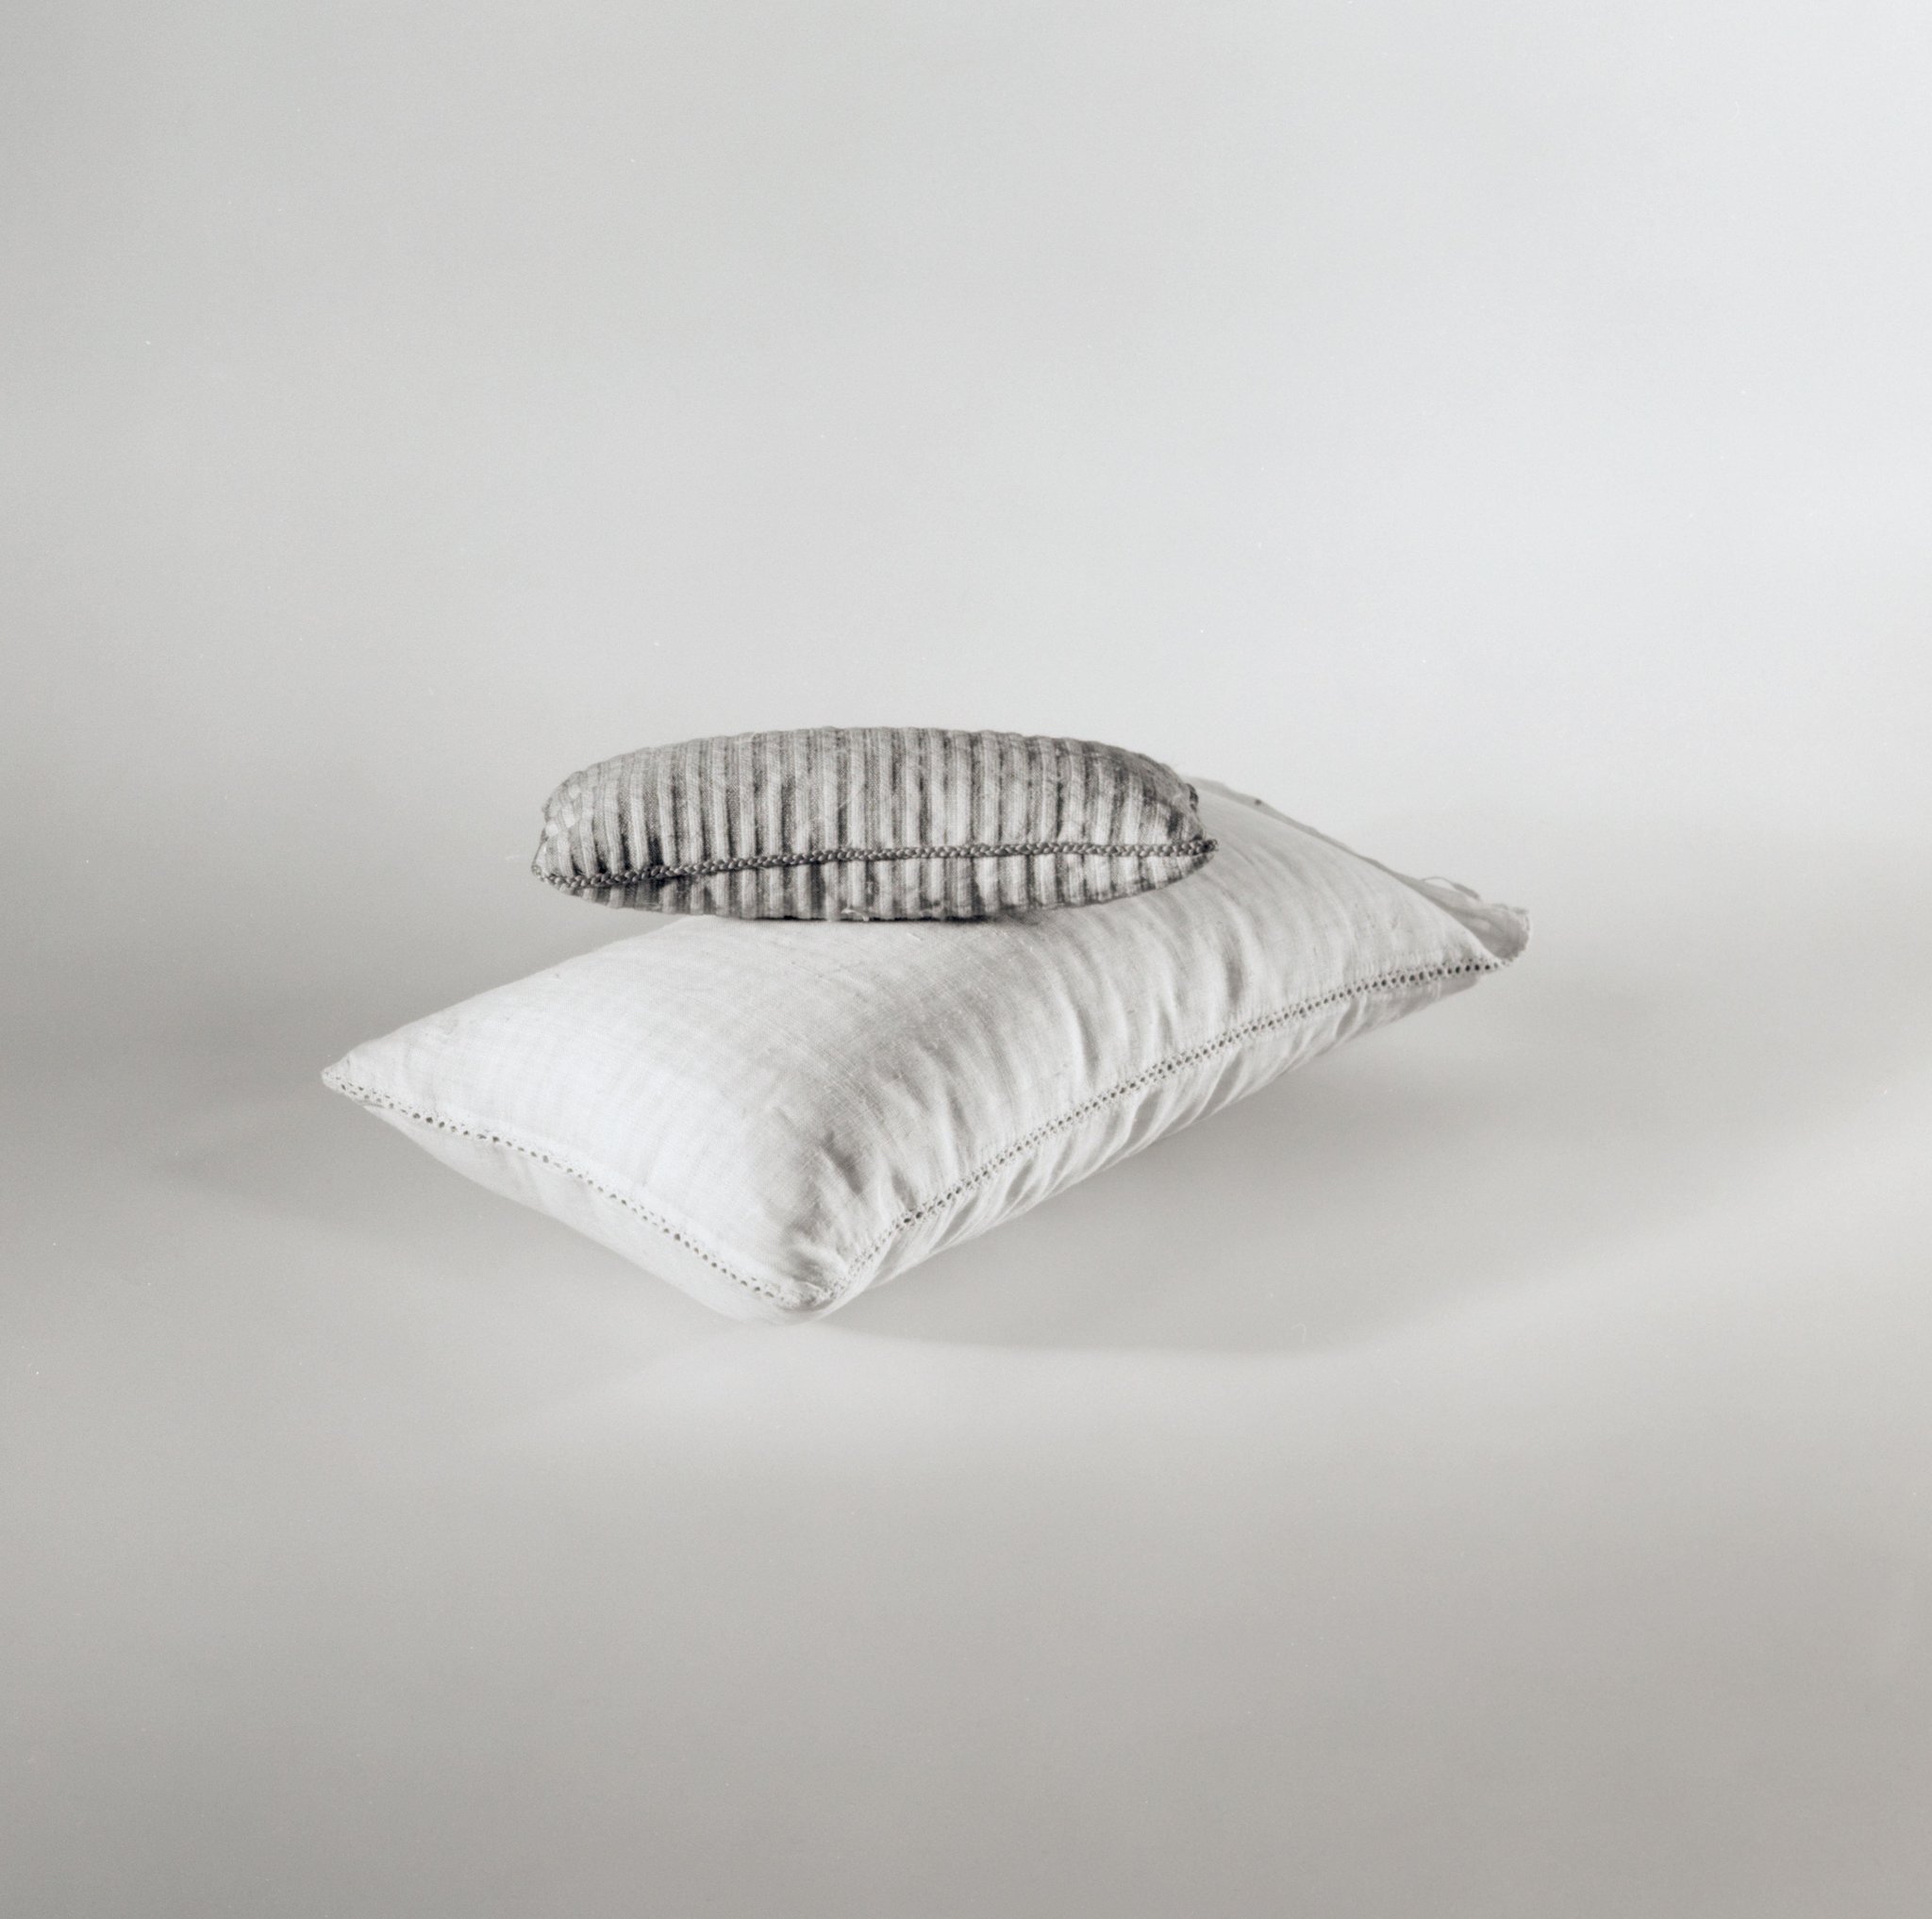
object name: bolster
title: Peluw, blauw-wit gestreept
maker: Anonymous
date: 1690-1710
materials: cotton, down, linen, silk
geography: amsterdam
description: Peluw van blauw-wit gestreept linnen- en katoenweefsel, omboord met gevlochten koordje van groene zijde. Het kussen is gevuld met dons.